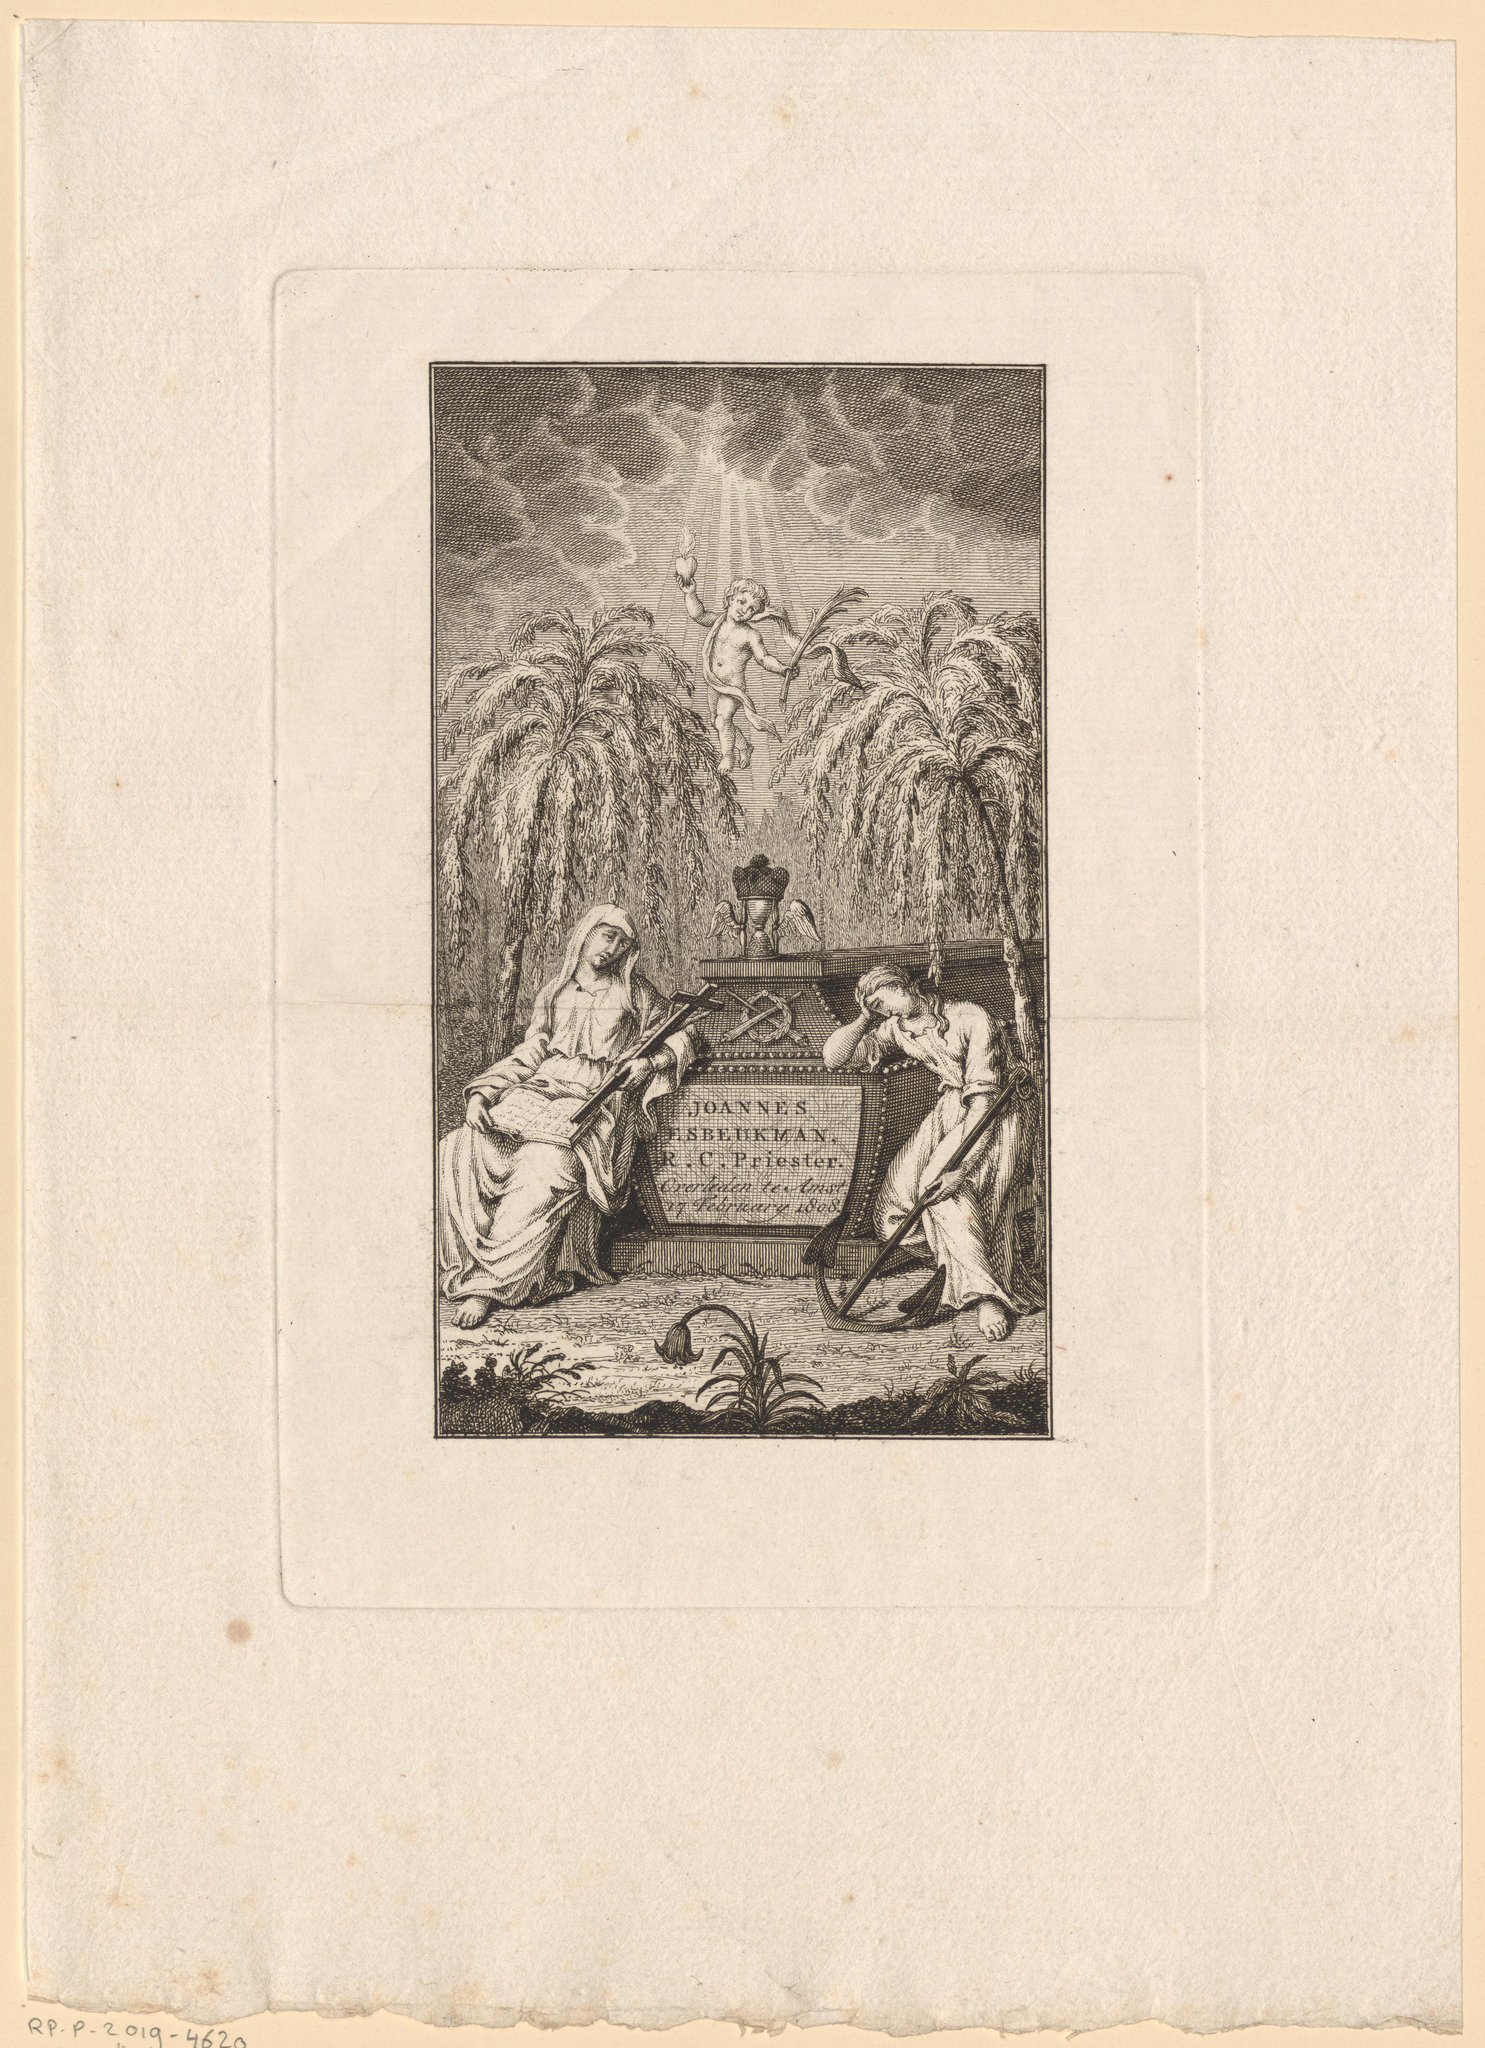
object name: print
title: Herdenkingsprent ter nagedachtenis aan Johannes Esbeukman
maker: Anonymous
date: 1808-1810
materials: paper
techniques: etching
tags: amsterdam, priest, faith, 'fides'; 'fede', 'fede catholica', 'fede christiana', 'fede christiana catholica' (ripa) ~ one of the three theological virtues, hope, 'spes'; 'speranza divina e certa' (ripa) ~ one of the three theological virtues, (personifications and symbolic representations of) love; 'amore (secondo seneca)' (ripa), coffin, hourglass